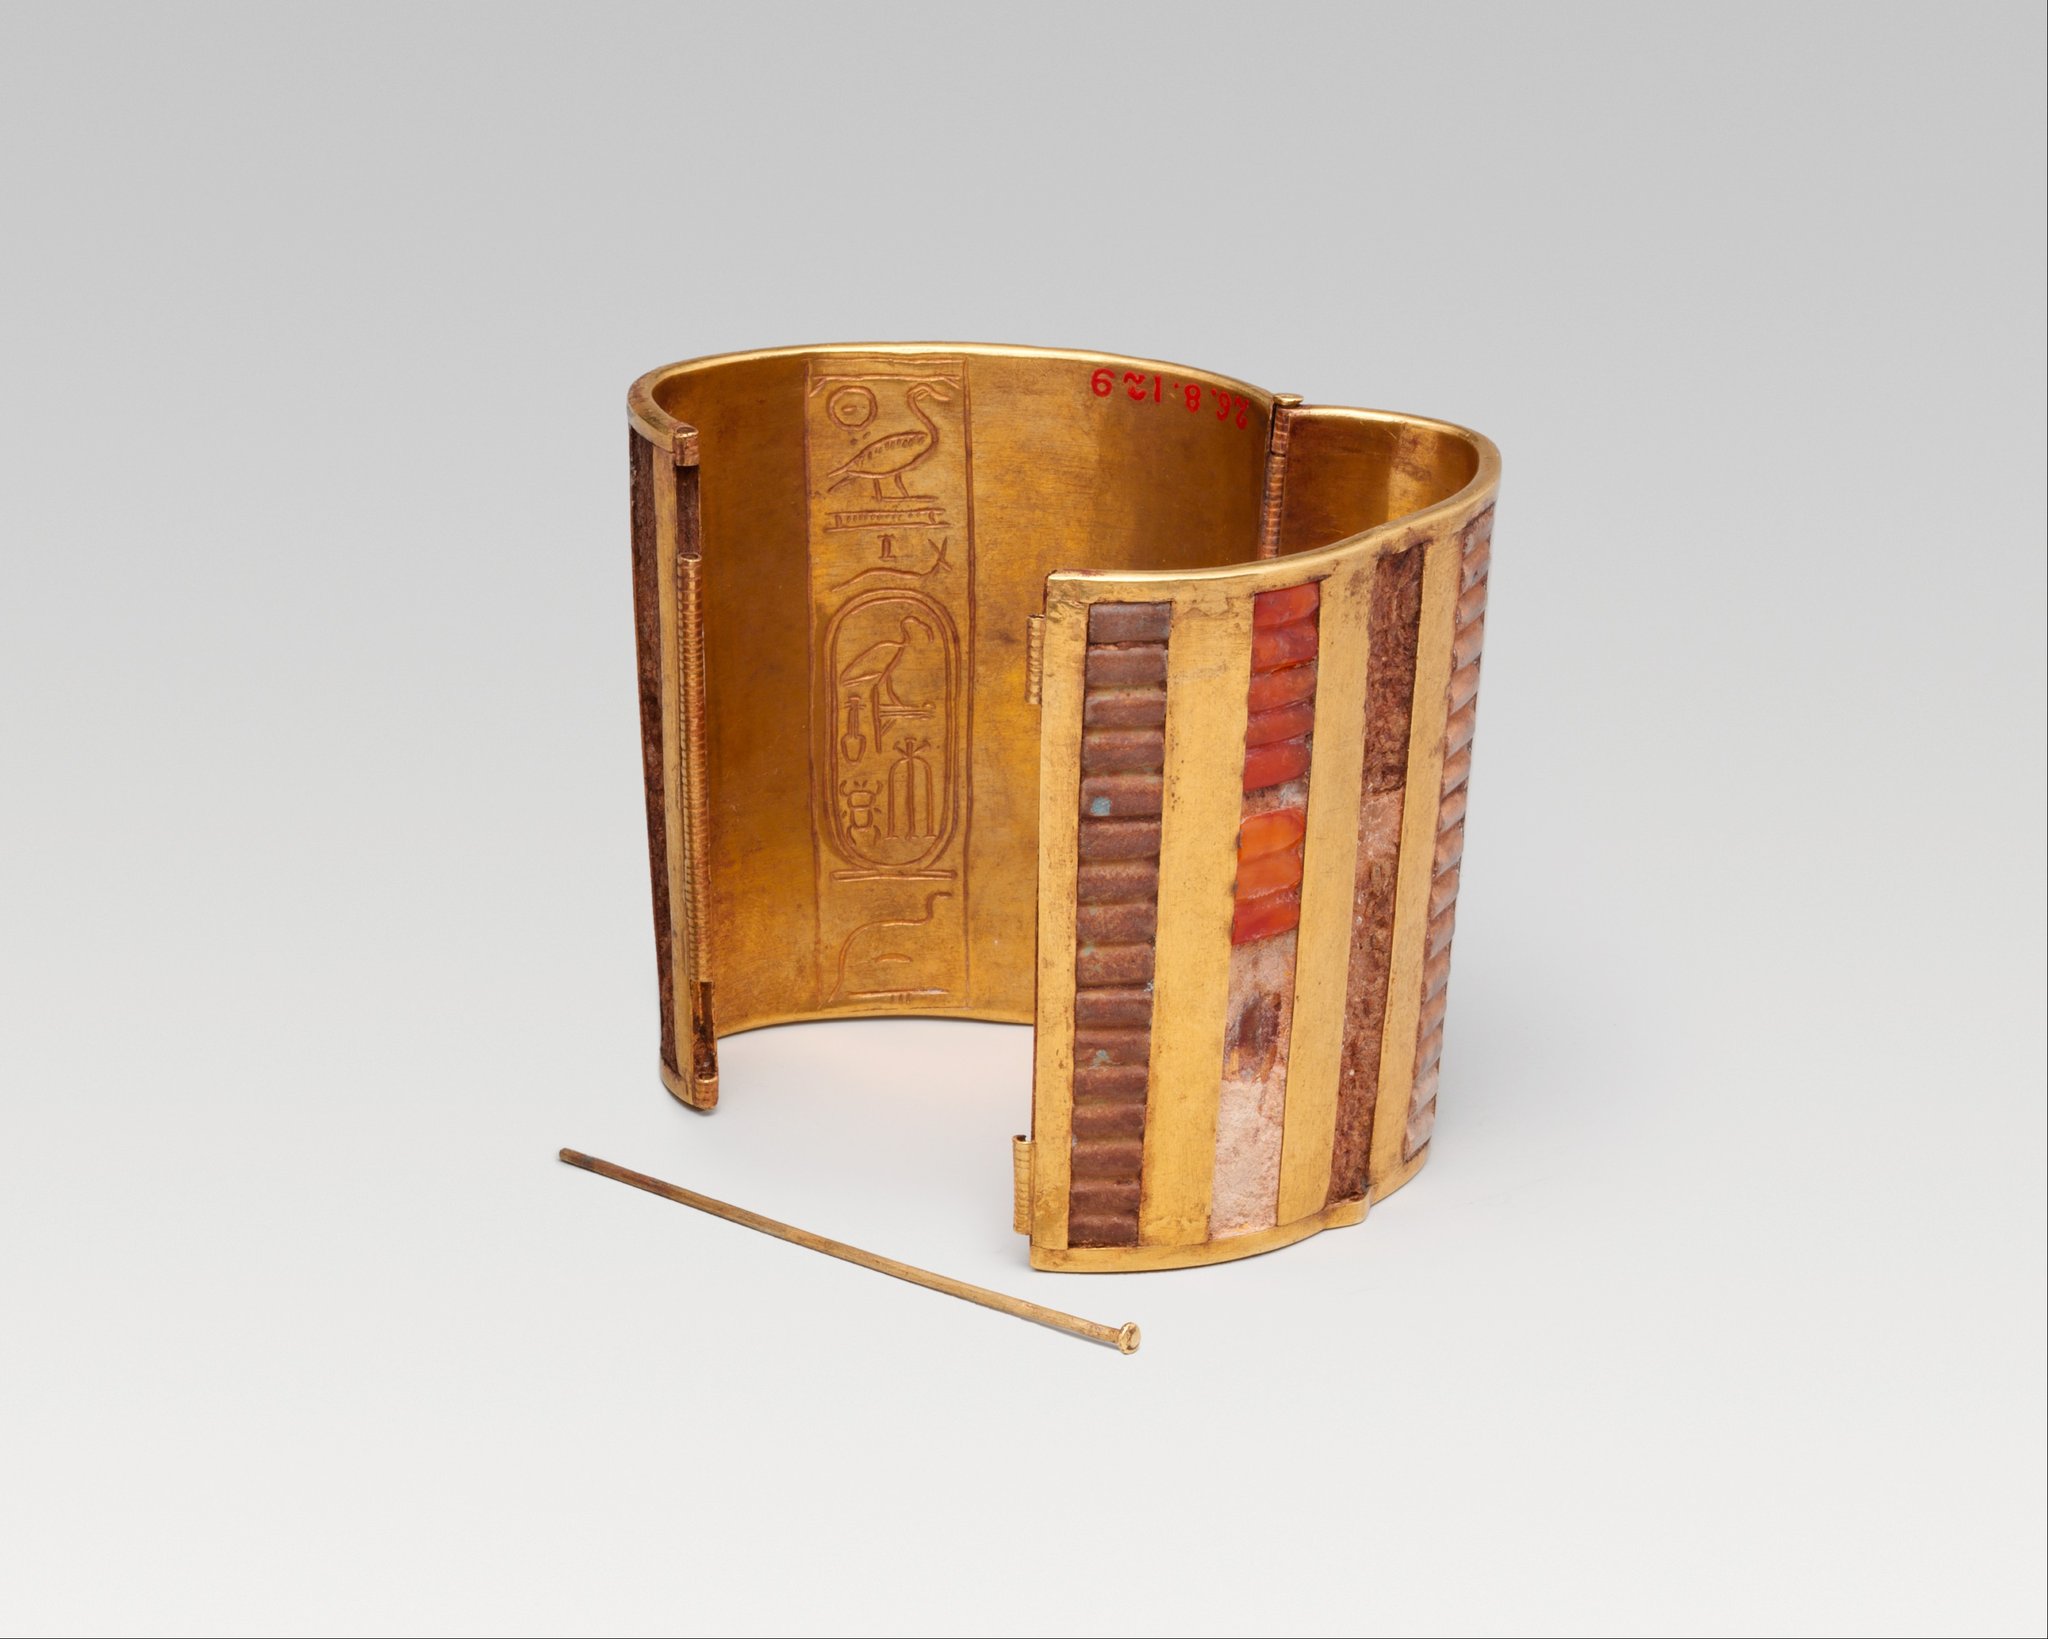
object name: hinged cuff bracelet with name of thutmose iii on the inside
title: Hinged Cuff Bracelet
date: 1479-1425 BCE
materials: gemstone, glass, gold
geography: egypt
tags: hieroglyphs